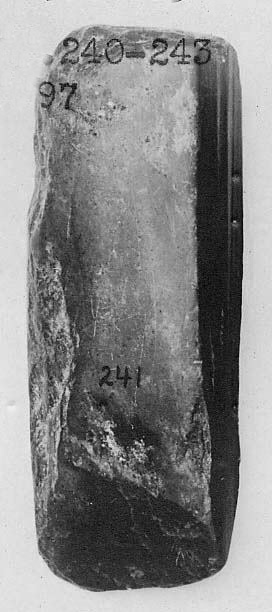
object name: axe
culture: north american, alaskan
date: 1902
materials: jade